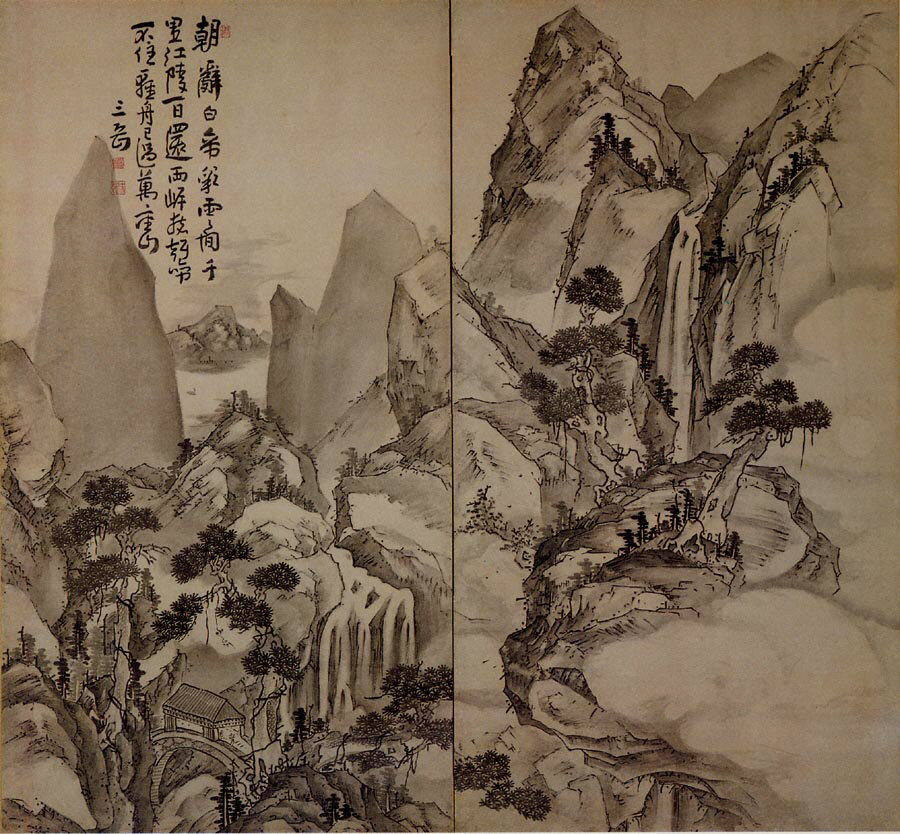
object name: screen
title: Landscape after Li Bai's poem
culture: japanese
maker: ike no taiga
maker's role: artist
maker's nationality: japanese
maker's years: 1723-1776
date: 1801-1900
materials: ink, panel, paper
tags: mountains,landscapes